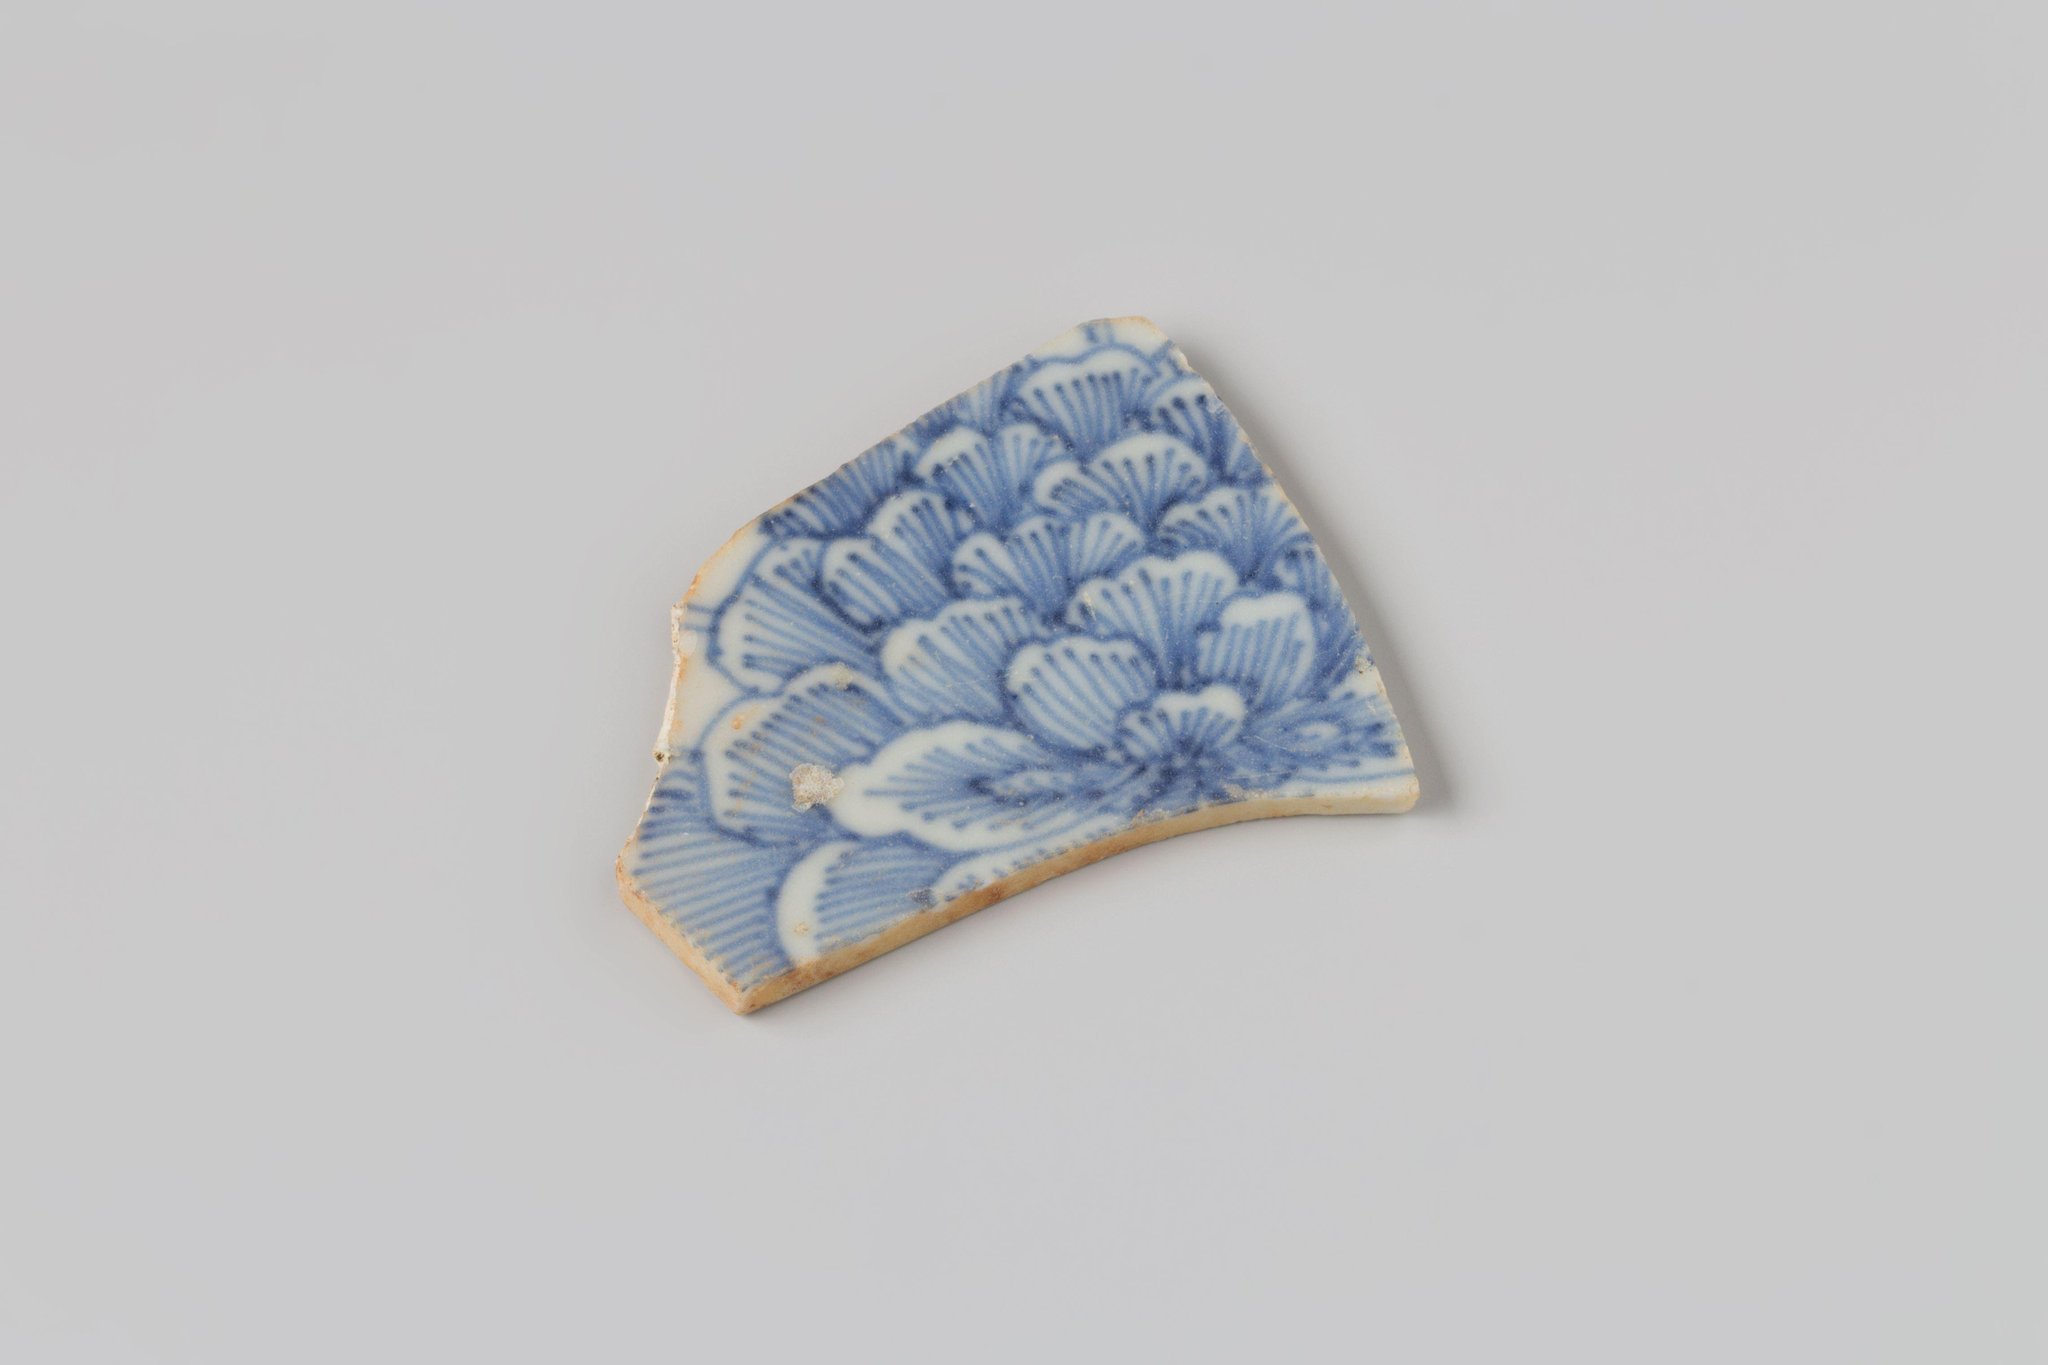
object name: plate dish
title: Scherf van een bord uit het wrak van de Oost-Indiëvaarder Hollandia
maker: Anonymous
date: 1700-1743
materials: porcelain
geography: netherlands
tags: verenigde oostindische compagnie, hollandia (schip), annet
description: Porcelain, plate, type 2; fragm of centre, sim. NG 1980-27H2624h.